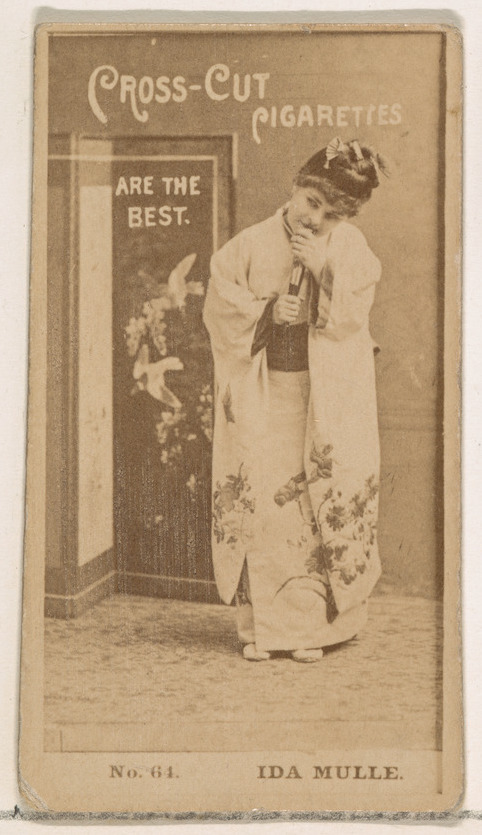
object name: print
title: Card Number 64, Ida Mulle, from the Actors and Actresses series (N145-2) issued by Duke Sons & Co. to promote Cross Cut Cigarettes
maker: w. duke, sons & co.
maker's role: publisher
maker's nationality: american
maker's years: 1870-1920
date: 1880-1889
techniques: albumen silver print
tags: portraits,women,actresses